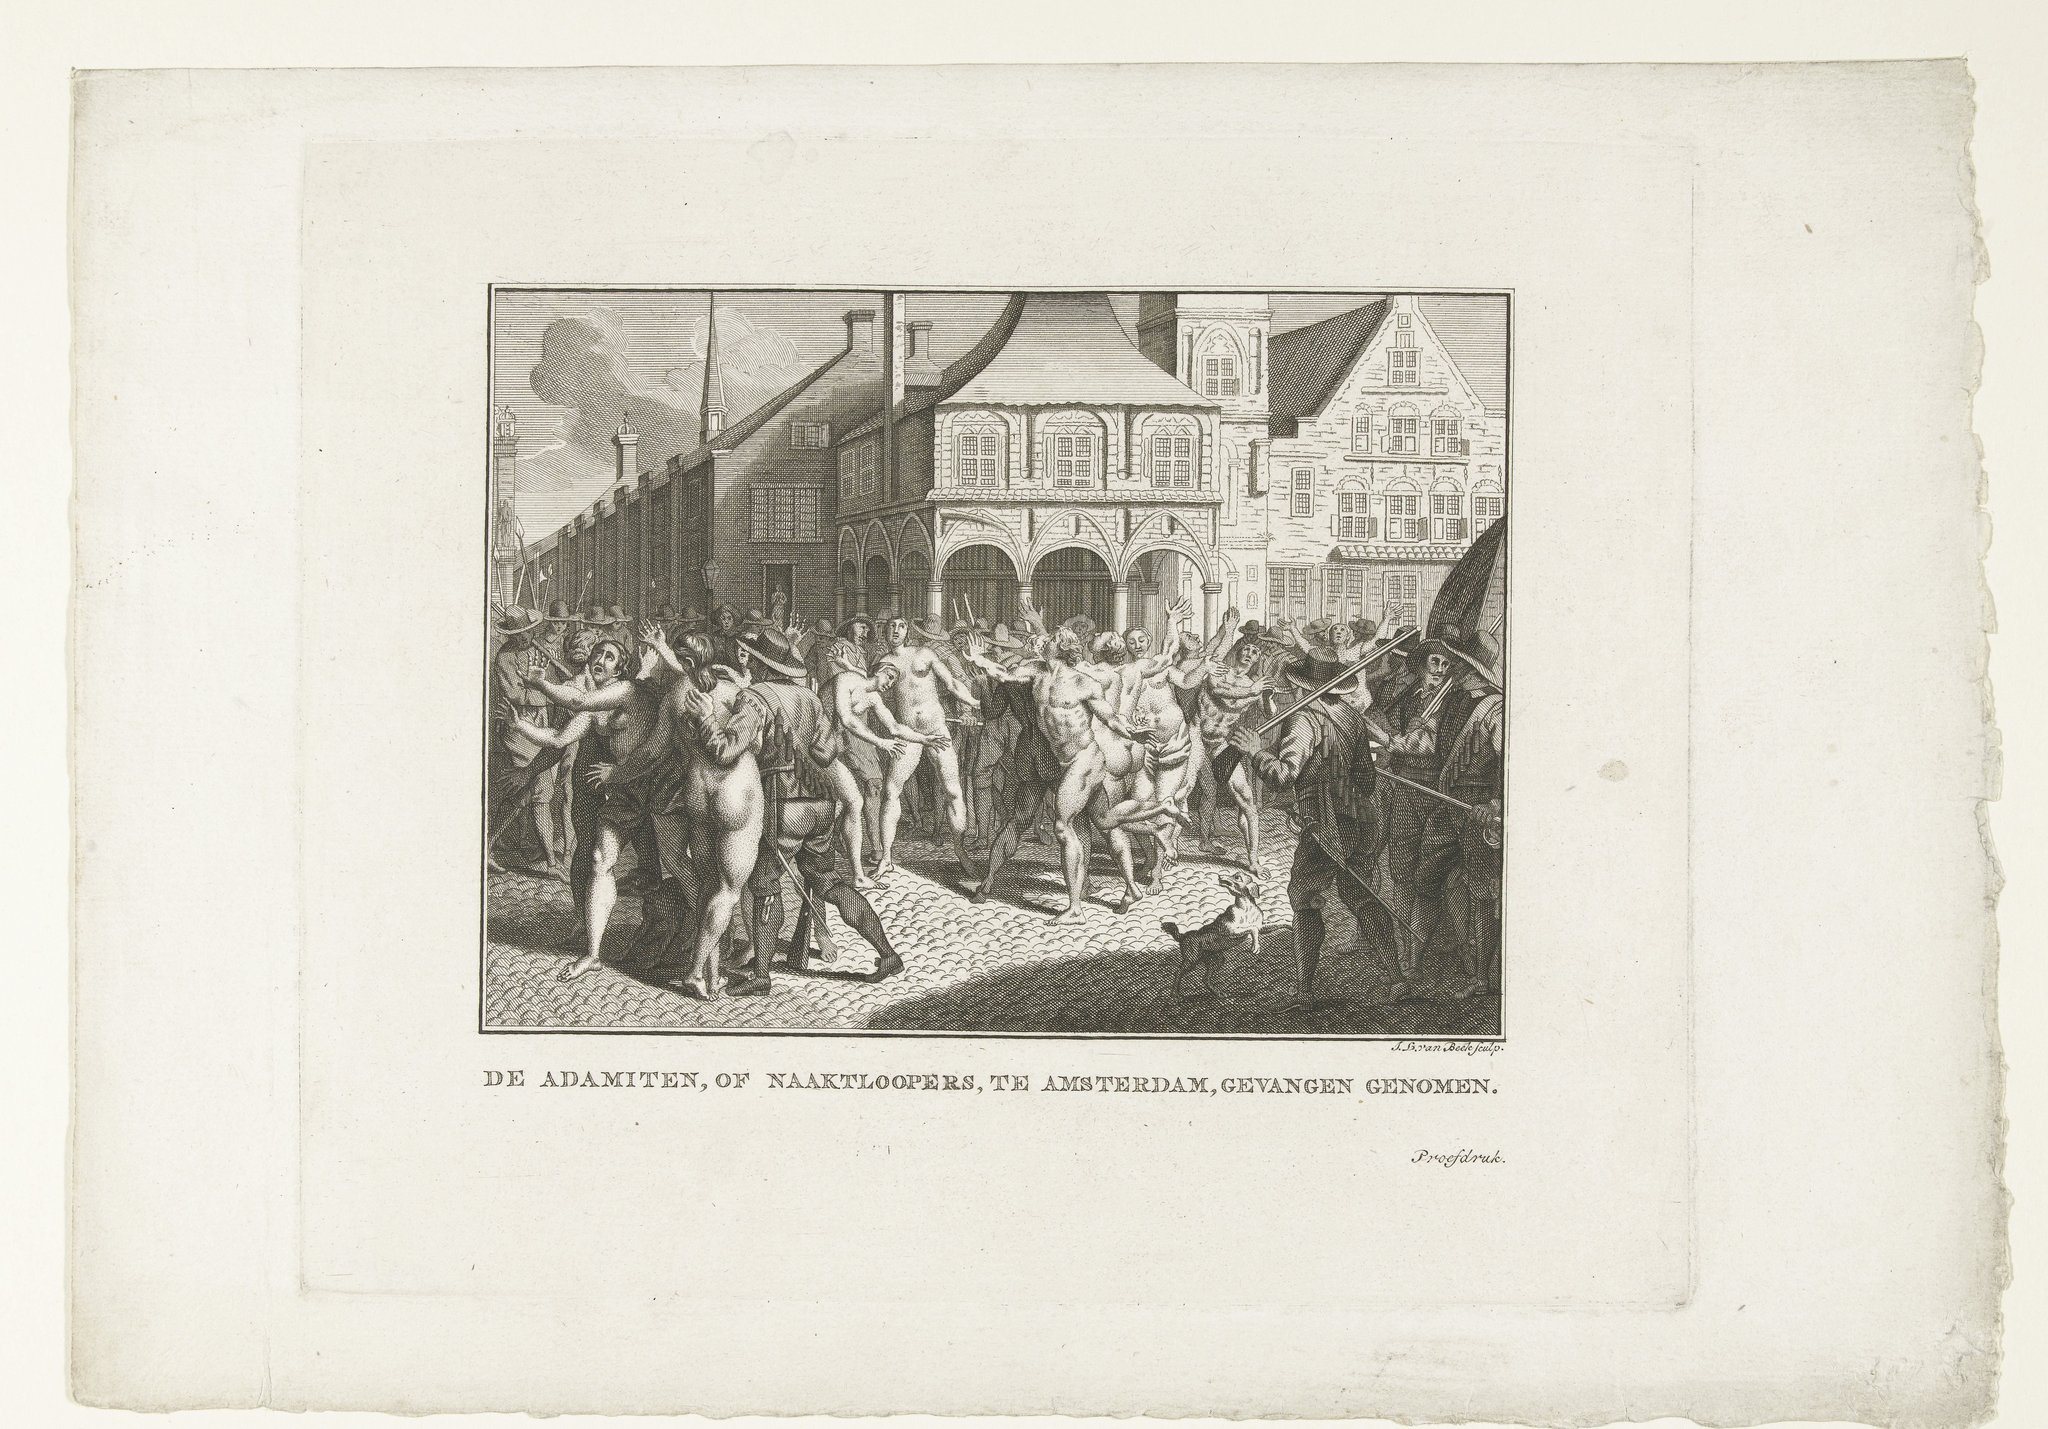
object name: print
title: Wederdopers lopen naakt over de Dam te Amsterdam, 1535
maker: jan lucas van der beek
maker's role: draughtsman, print maker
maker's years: 1753-1818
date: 1723-1818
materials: paper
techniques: etching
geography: netherlands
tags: dam, stadhuis van amsterdam (14e eeuw-1652), wederdopersoproer in amsterdam en friesland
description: Kopie naar FMH 388 (RP-P-OB-78.514). Niet in Frederik Muller; door het RPK toegevoegd nummer.